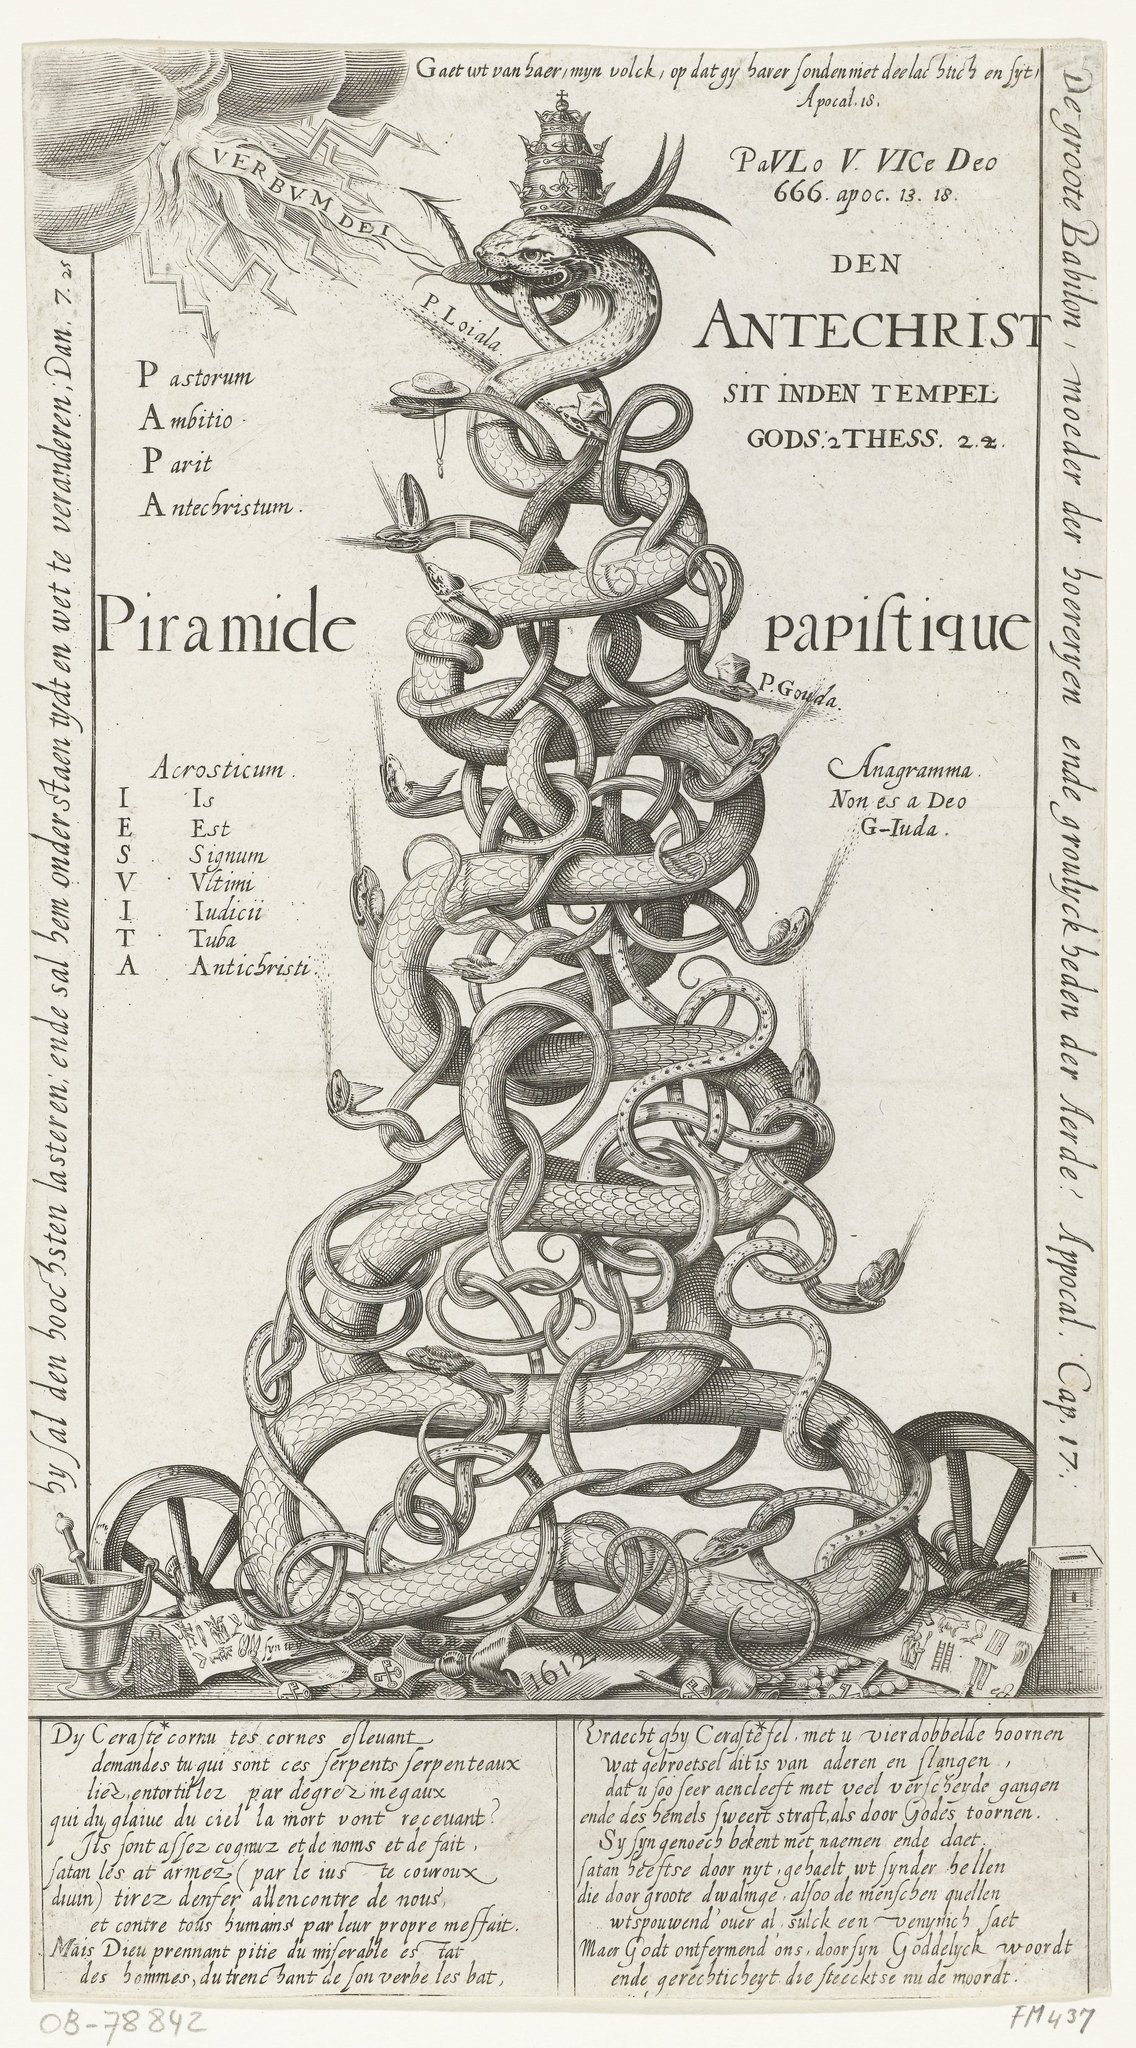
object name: print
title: Paapse piramide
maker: hendrick hondius (i)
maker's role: draughtsman, print maker, publisher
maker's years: 1573-1650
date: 1597-1601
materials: paper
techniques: engraving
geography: northern netherlands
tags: rome, clergyman, utrecht, brussels, reformation (roman catholic church vs. protestantism), snakes, pope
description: Paapse piramide, 1612. Piramide gevormd door een grote slang voorstellende het pausdom en vele kleine slangetjes die andere elementen van de katholieke kerk symboliseren. Twee kleine slangen worden aangeduid als Loyola en pater Johannes de Gouda. Linksboven het Woord Gods uit een donderwolk. Op de grond allerlei gebruiksobjecten uit de roomse kerk. Met opschriften in de voorstelling in het Latijn en Nederlands. Met onderschrift van 2 kolommen met elk 10 regels in het Frans en het Nederlands. Spotprent op de paus en de Roomse kerk, ca. 1560.